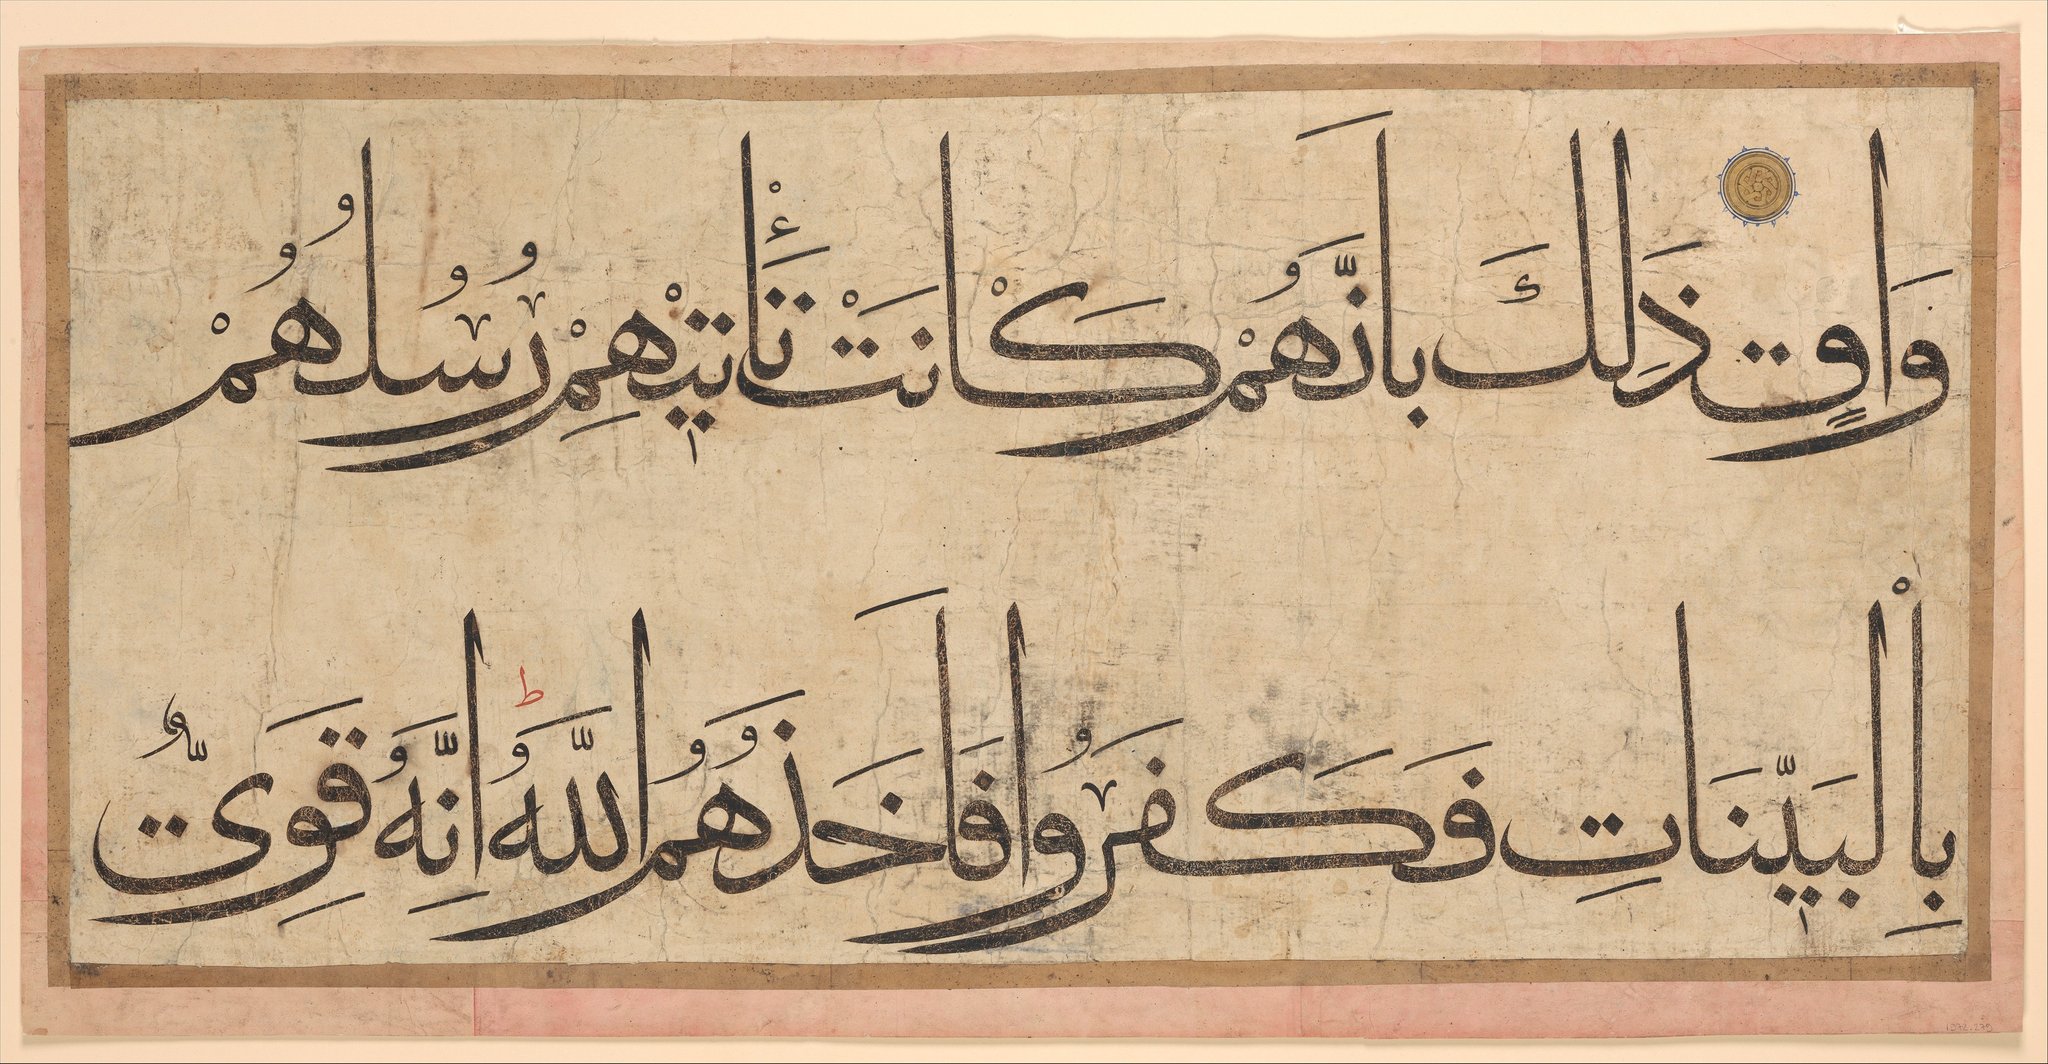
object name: section from a non illustrated manuscript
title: Section of a Qur'an Manuscript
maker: `umar aqta'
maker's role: calligrapher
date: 1367-1433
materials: gold, ink, paper, watercolor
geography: uzbekistan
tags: qur'an,calligraphy